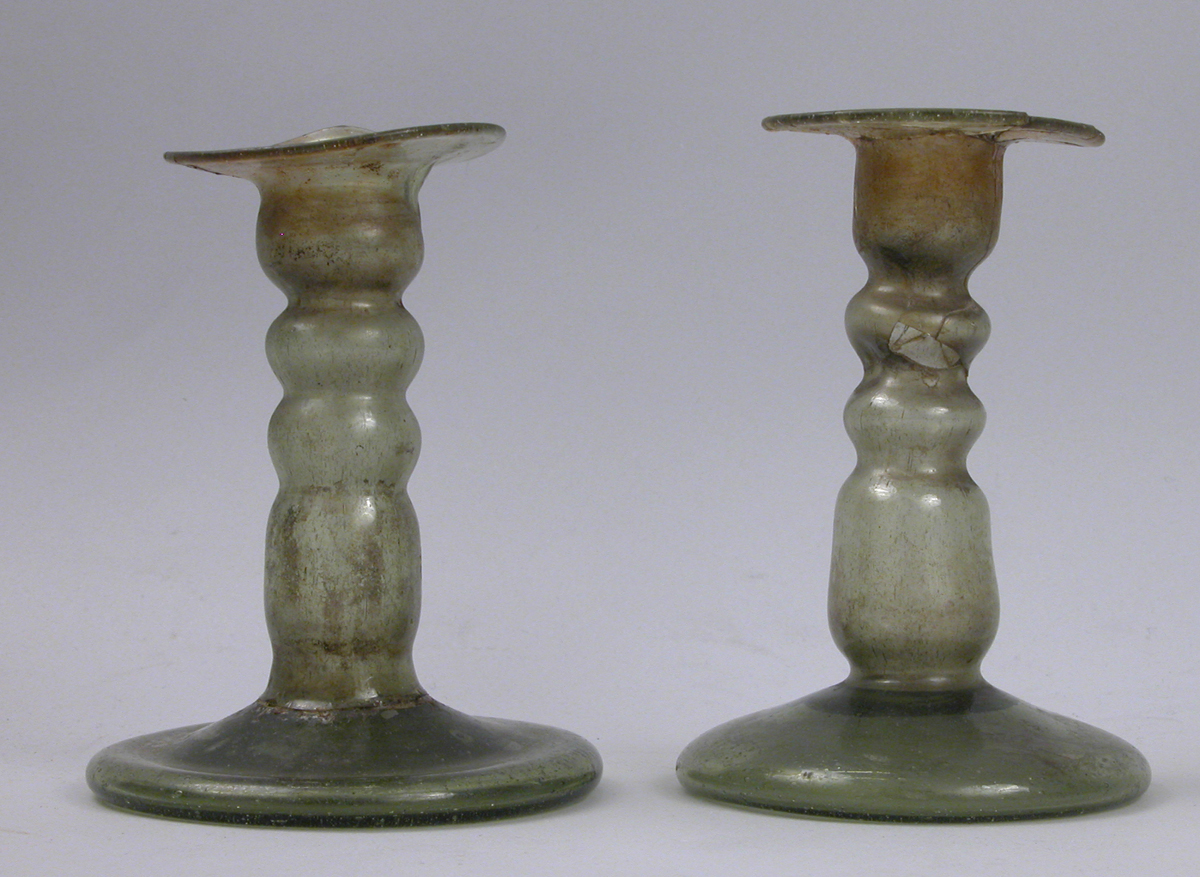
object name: candlestick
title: Candlesticks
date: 868-905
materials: glass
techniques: glassblowing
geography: egypt